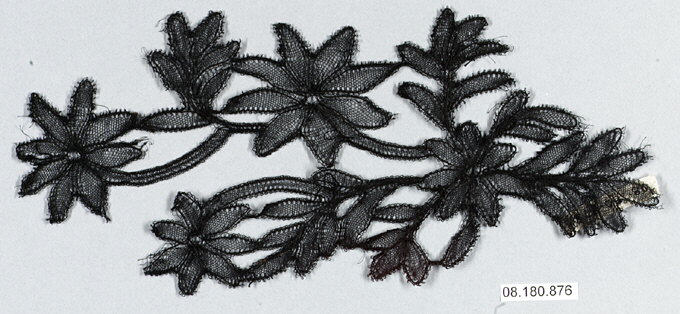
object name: piece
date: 1801-1900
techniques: lace